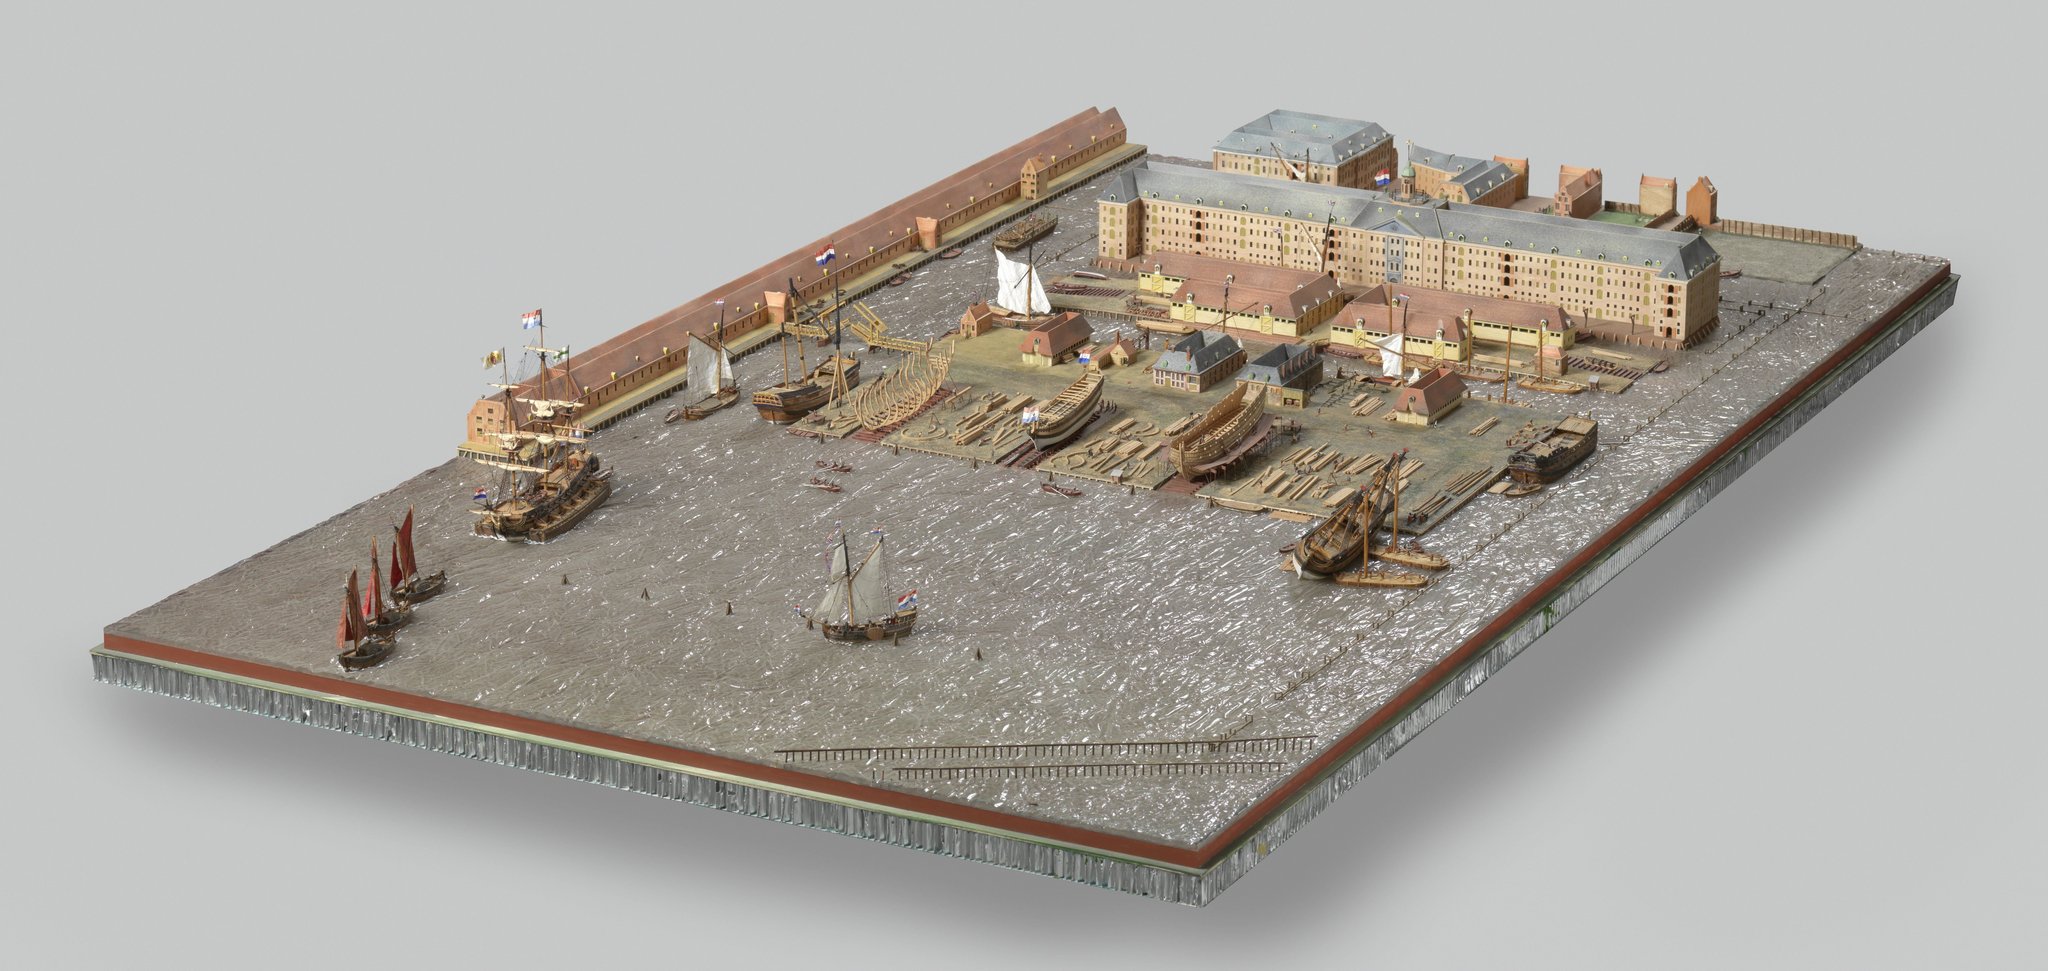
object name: maquette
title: Model of the Dockyard of the Dutch East India Company at Oostenburg in Amsterdam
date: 1988-1989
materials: wood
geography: amsterdam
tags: amsterdam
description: Maquette van de VOC-werf op het eiland Oostenburg te Amsterdam, met het centrale pakhuis over de volle breedte van de werf. Deze is aan drie zijden omgeven door water en aan een zijde door de lijnbaan. Op de werf zijn modellen van enkele schepen in verschillende stadia van ontwikkeling, op het water wordt een schip in scheepskamelen voortgetrokken door drie waterschepen.